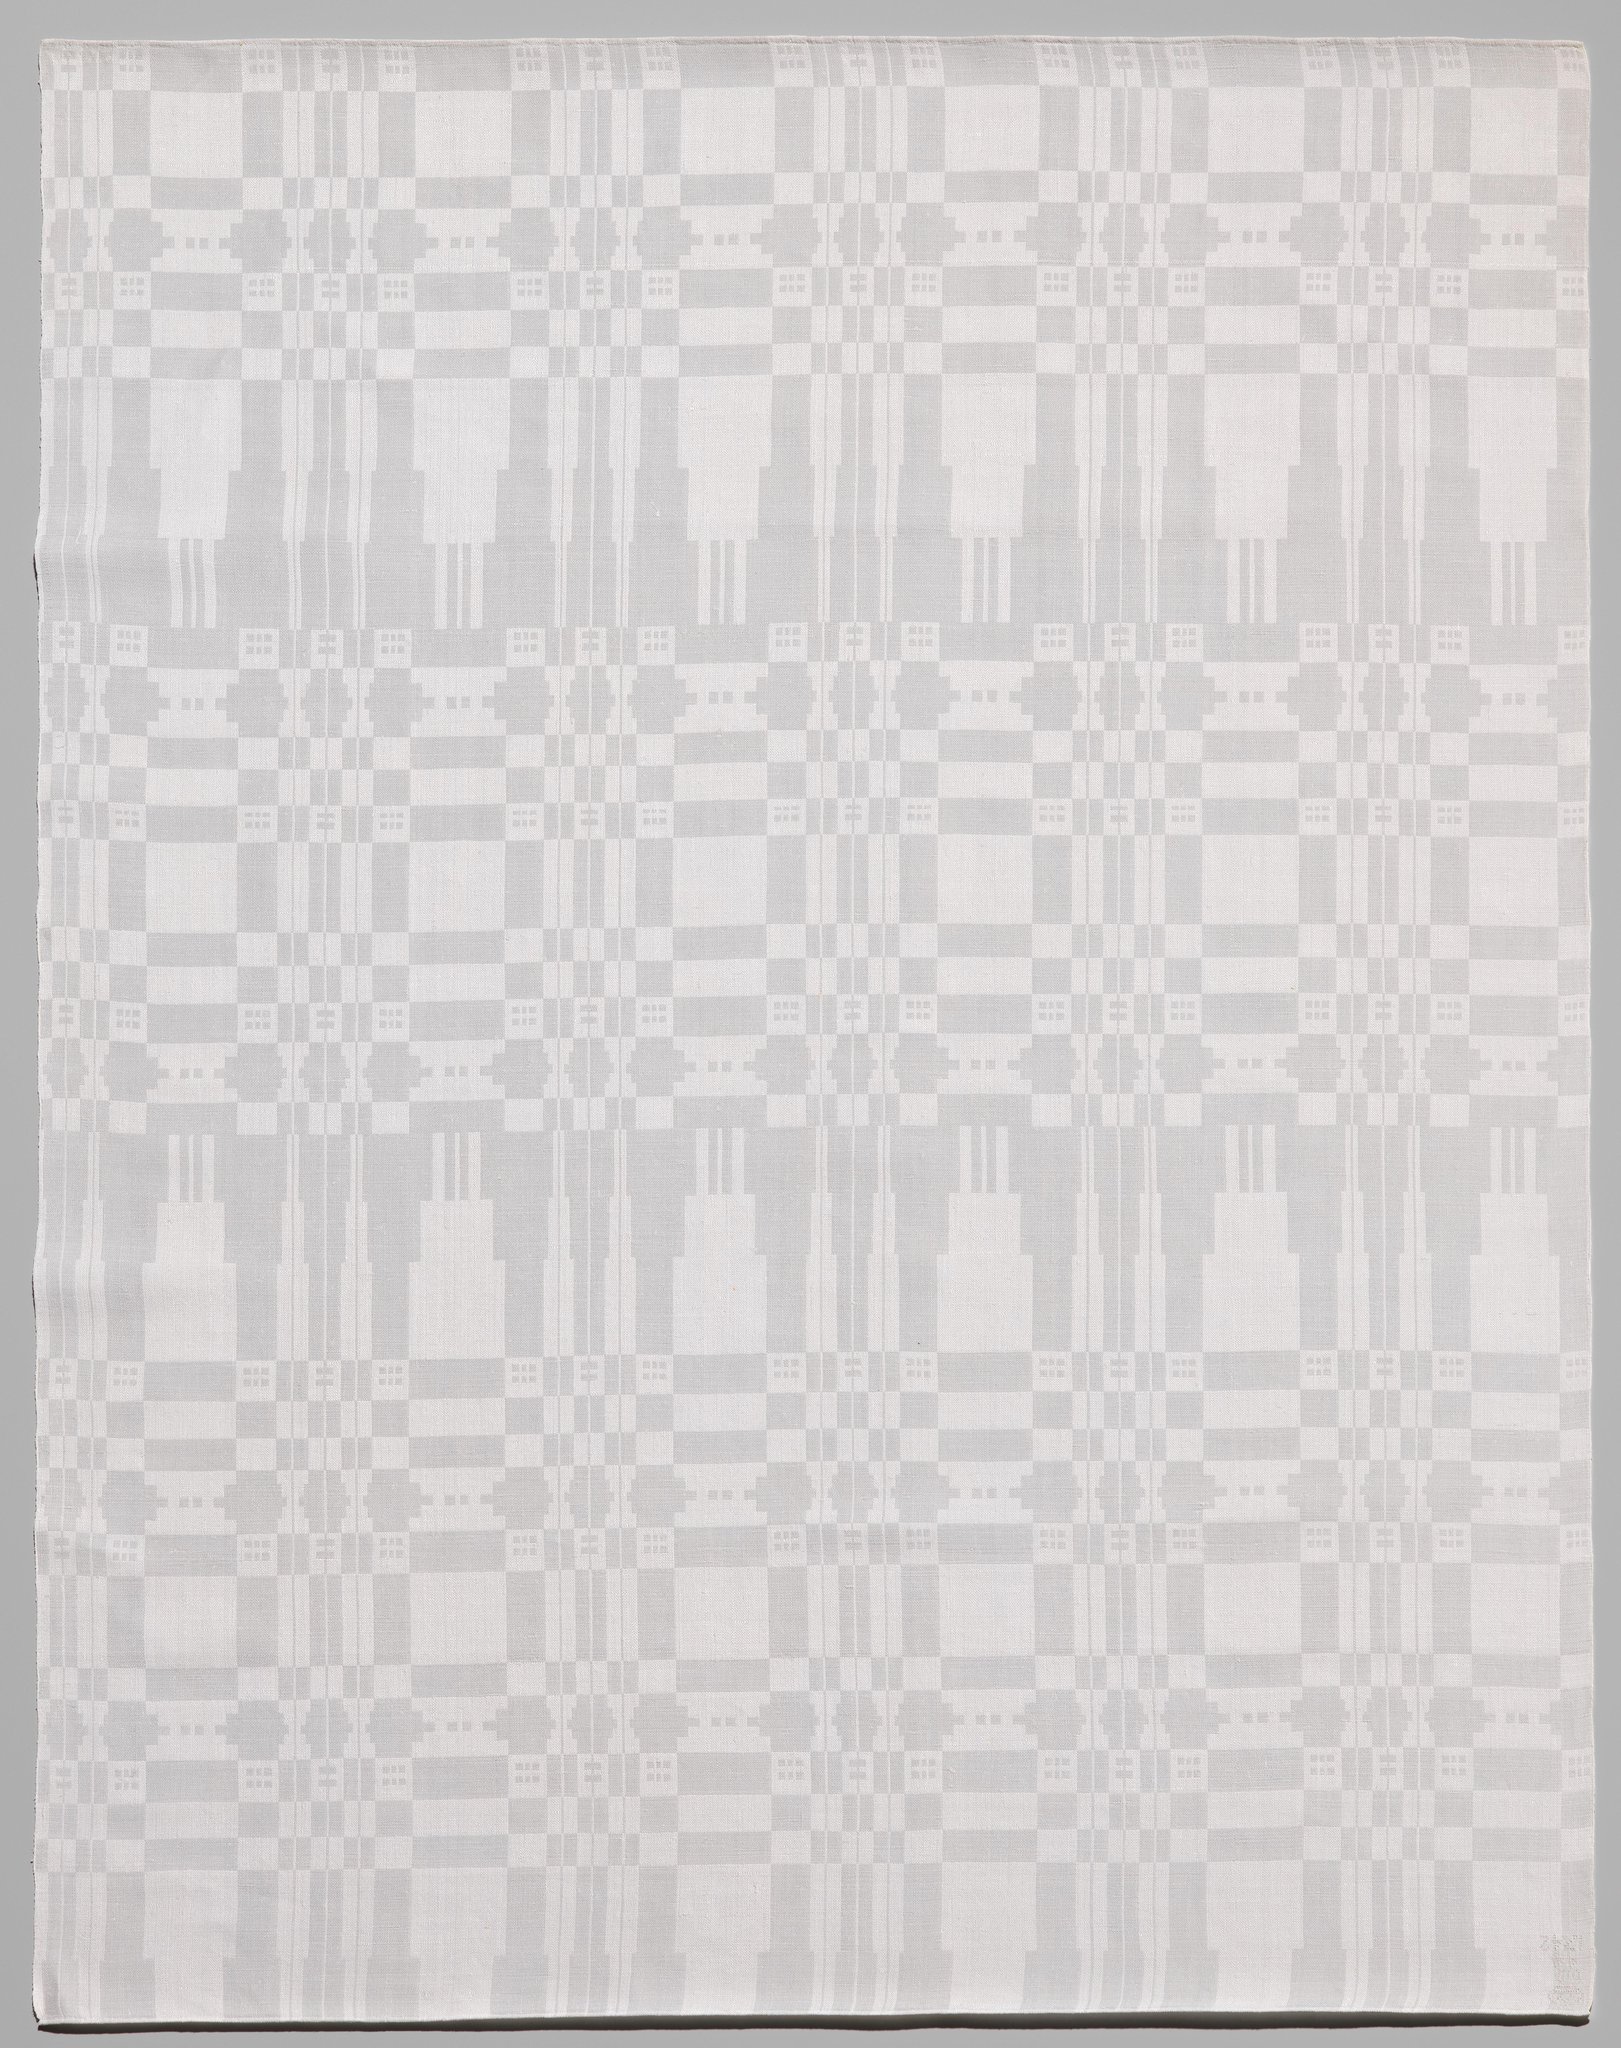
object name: napkin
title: Servet van linnen met pellenpatroon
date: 1742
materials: linen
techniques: peeled fabric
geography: northern netherlands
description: Wit linnendamasten servet met pellenpatroon, genaamd "Torenwerk". Merk kroon WG 44 1742.